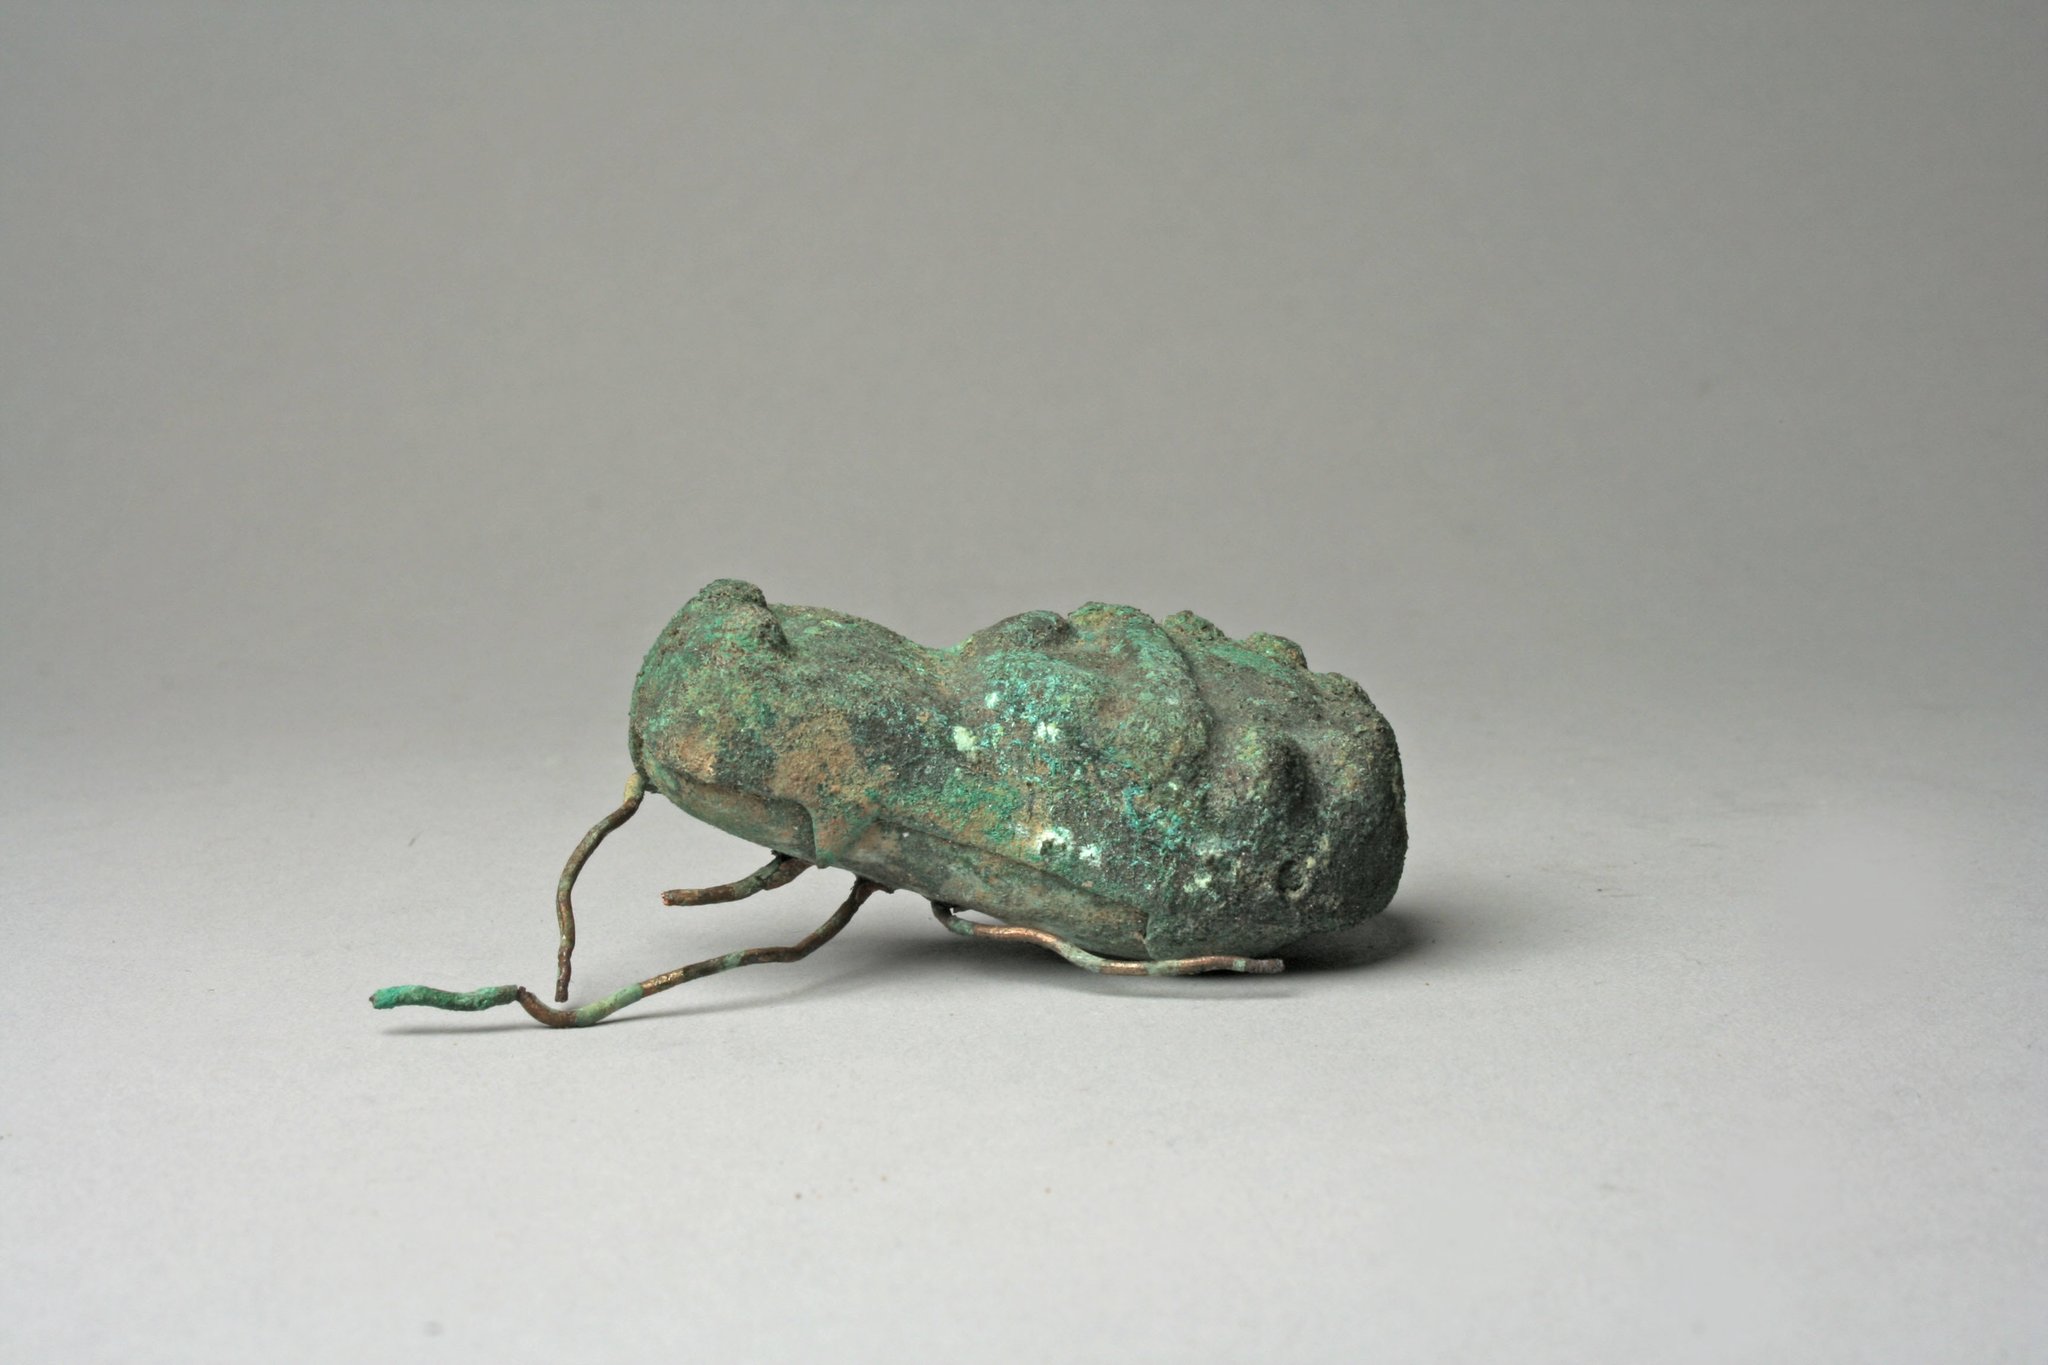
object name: ornament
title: Spider Ornament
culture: moche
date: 501-700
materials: metal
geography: peru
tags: insects